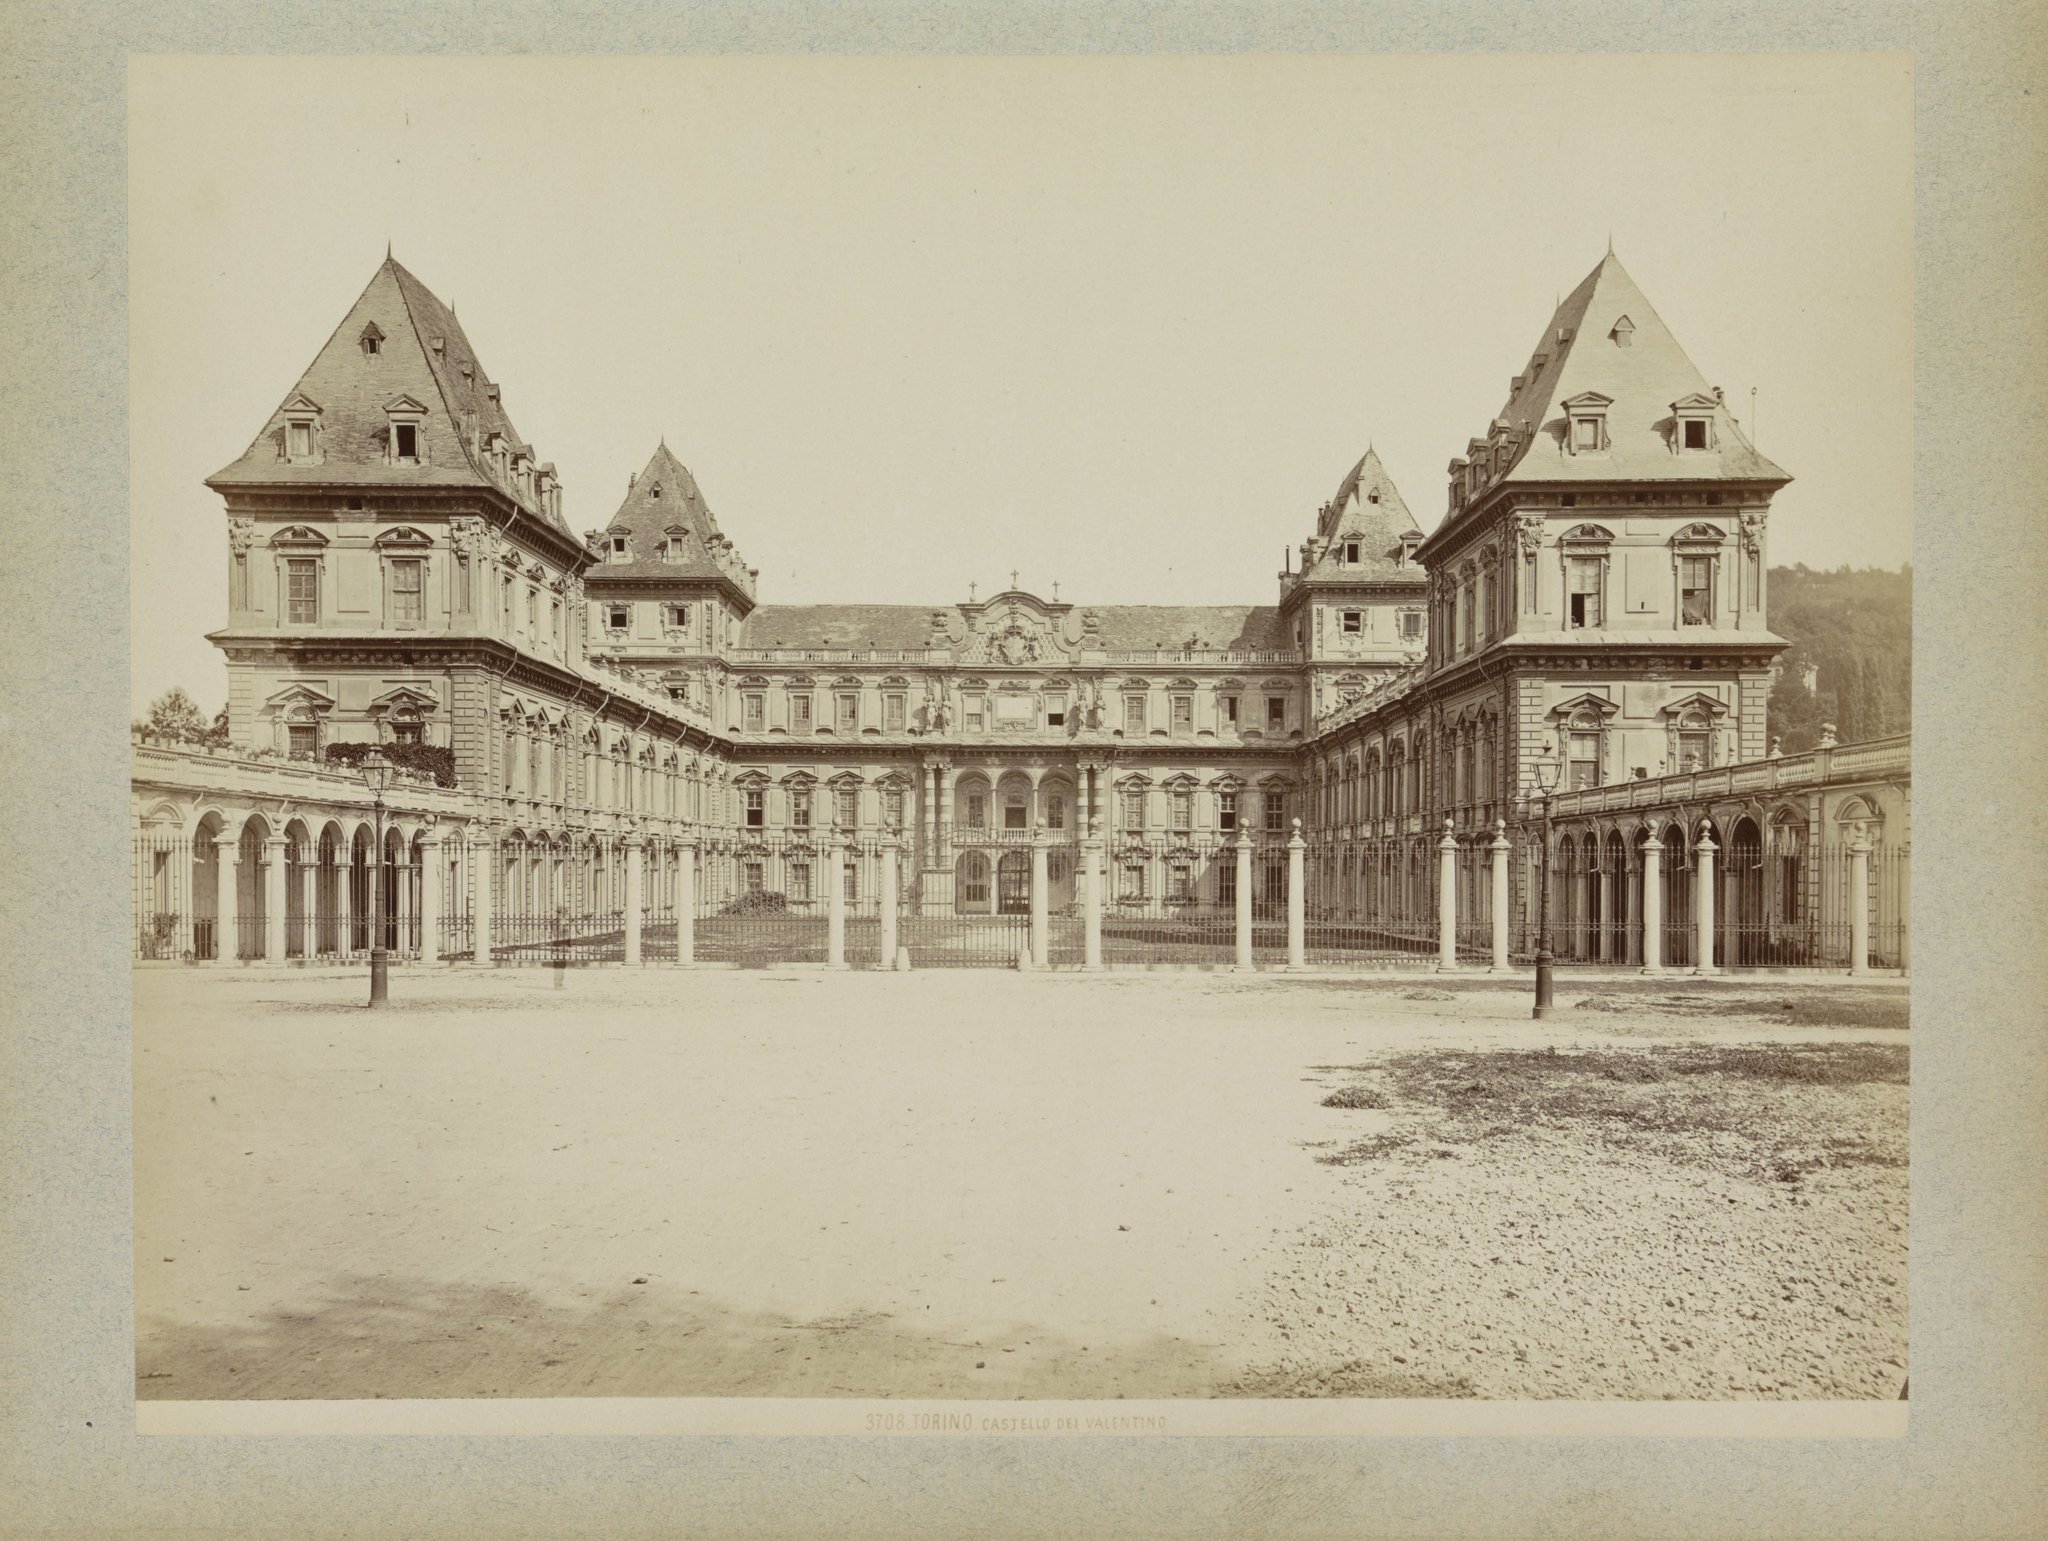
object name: photograph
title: Castello del Valentino in Turijn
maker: Anonymous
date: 1885-1900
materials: paper, photographic support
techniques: albumen print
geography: turin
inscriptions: caption: ‘3708 Torino Castello del Valentino’